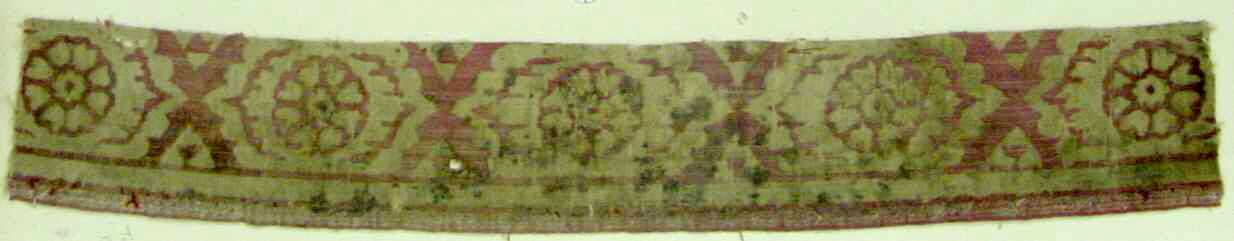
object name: textile fragment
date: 1601-1700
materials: silk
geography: turkey